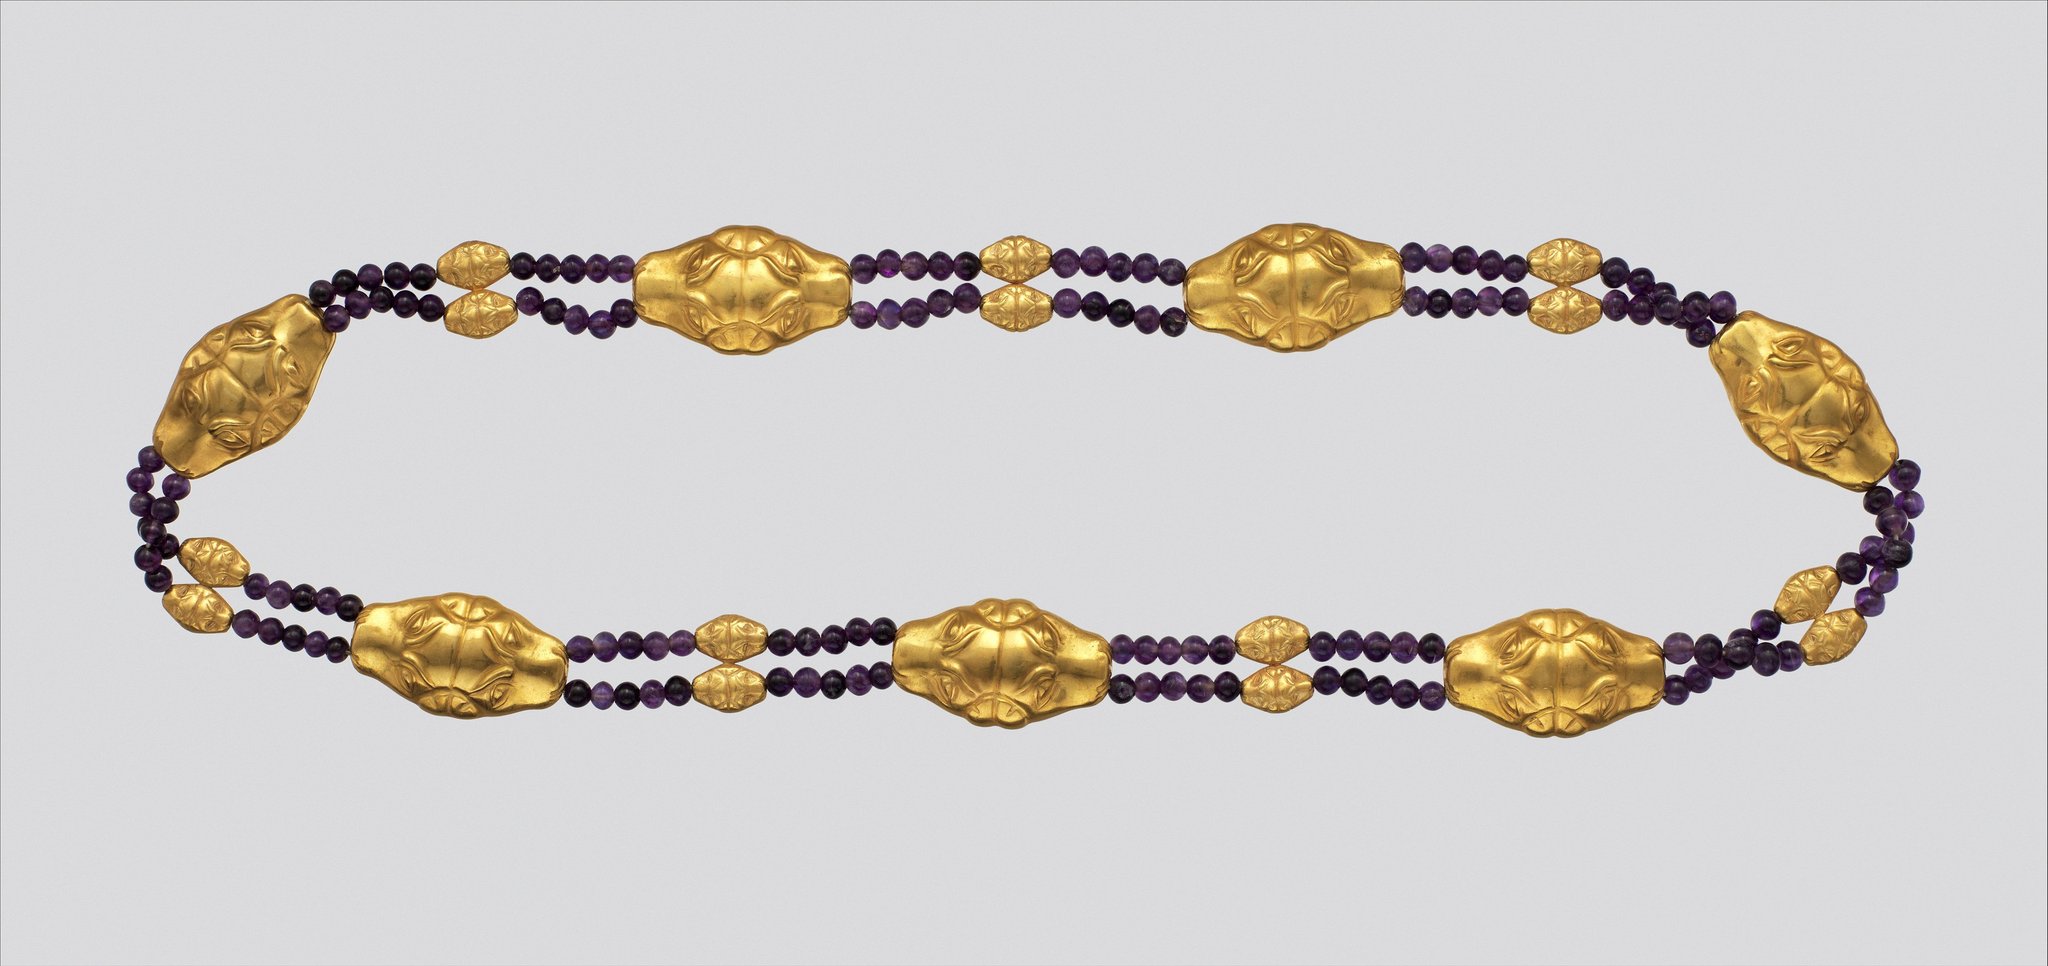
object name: girdle, sithathoryunet, leopard head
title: Leopard-Head Girdle of Sithathoryunet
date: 1887-1813 BCE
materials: gemstone, gold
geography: egypt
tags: leopards